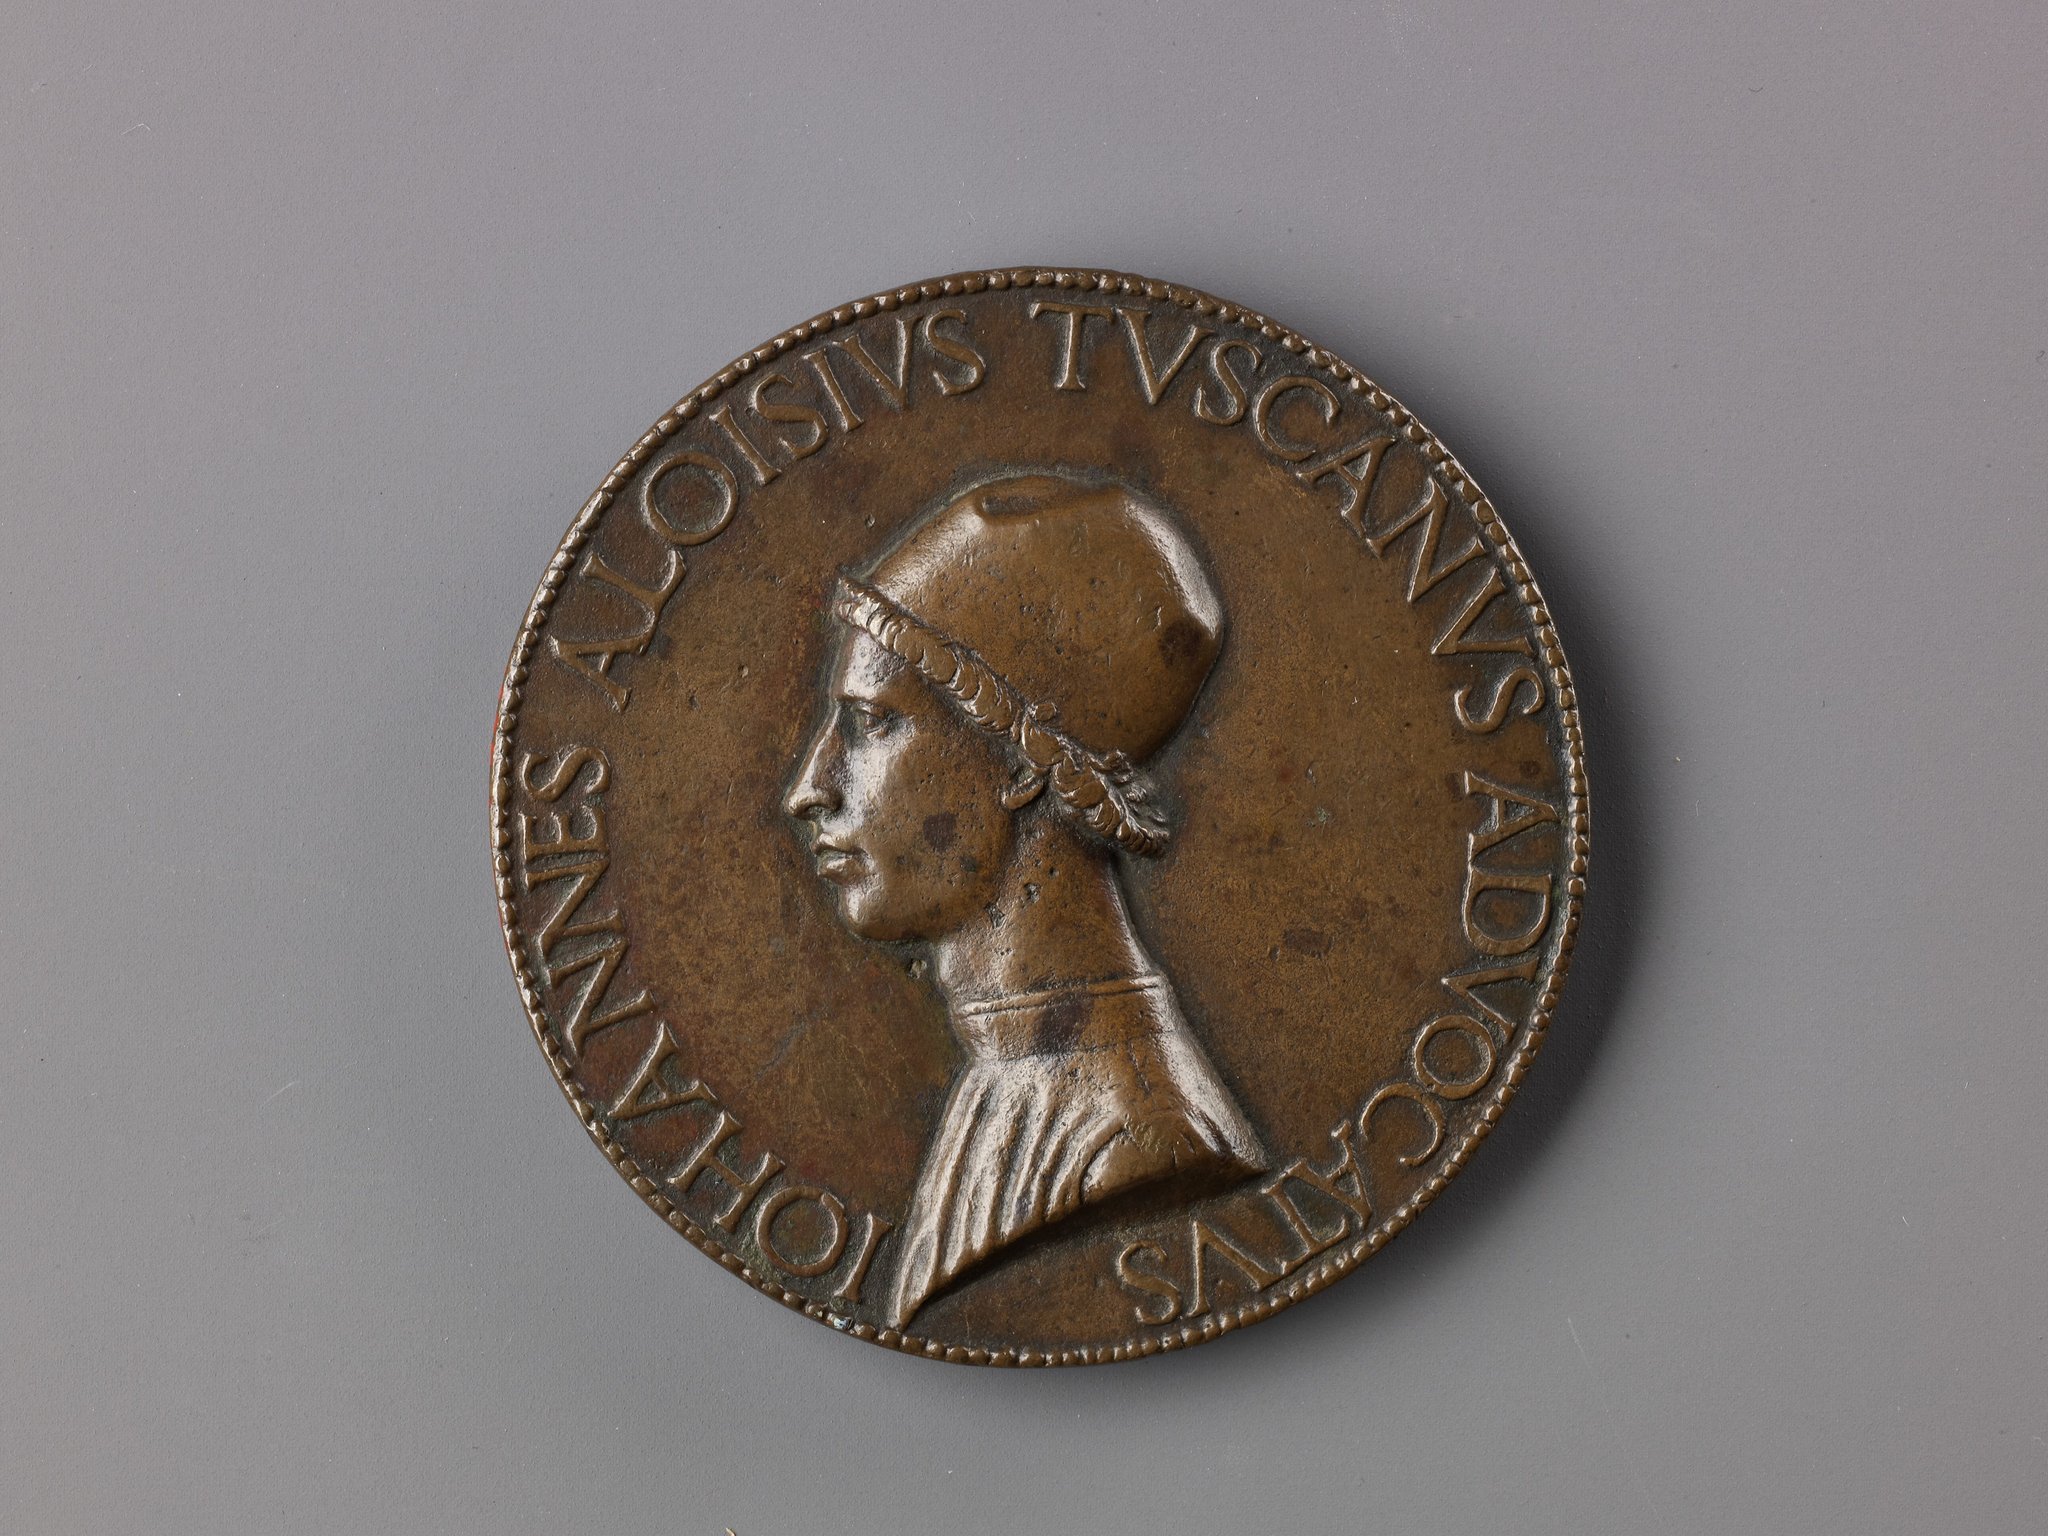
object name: medal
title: Portrait medal of Giovanni Alvise Toscani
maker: lysippus the younger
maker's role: artist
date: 1475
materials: bronze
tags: men,portraits,profiles